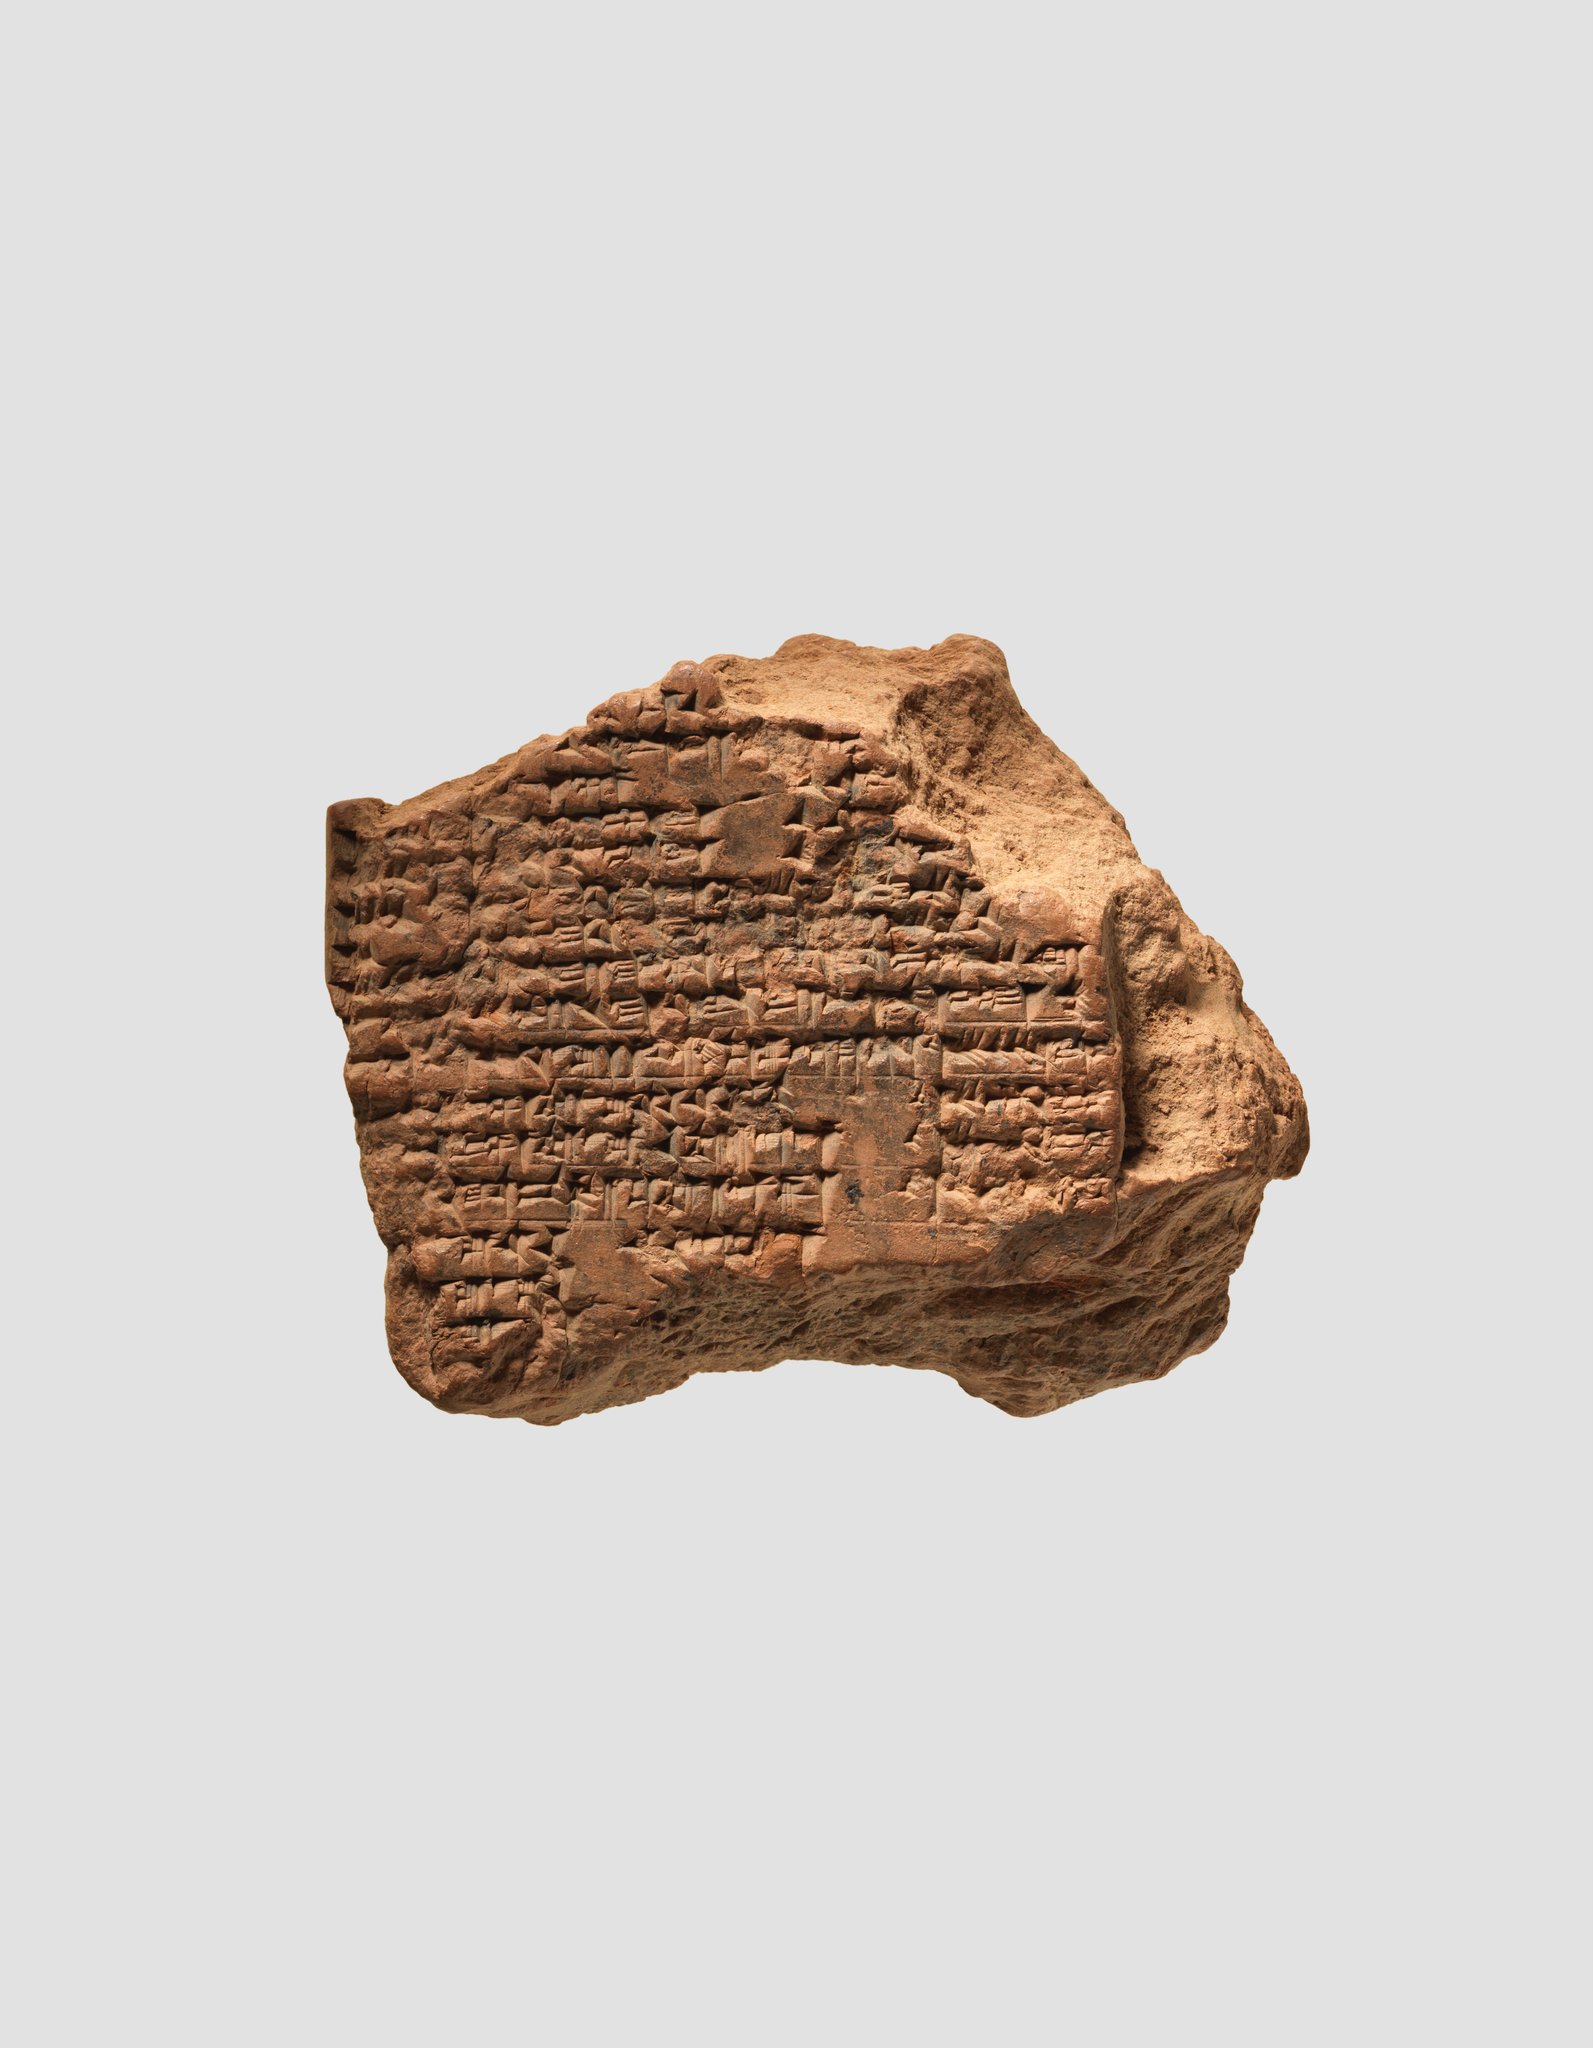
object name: cuneiform tablet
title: Cuneiform tablet: Enuma Anu Enlil, tablets 26 and 27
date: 333-1 BCE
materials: clay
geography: mesopotamia